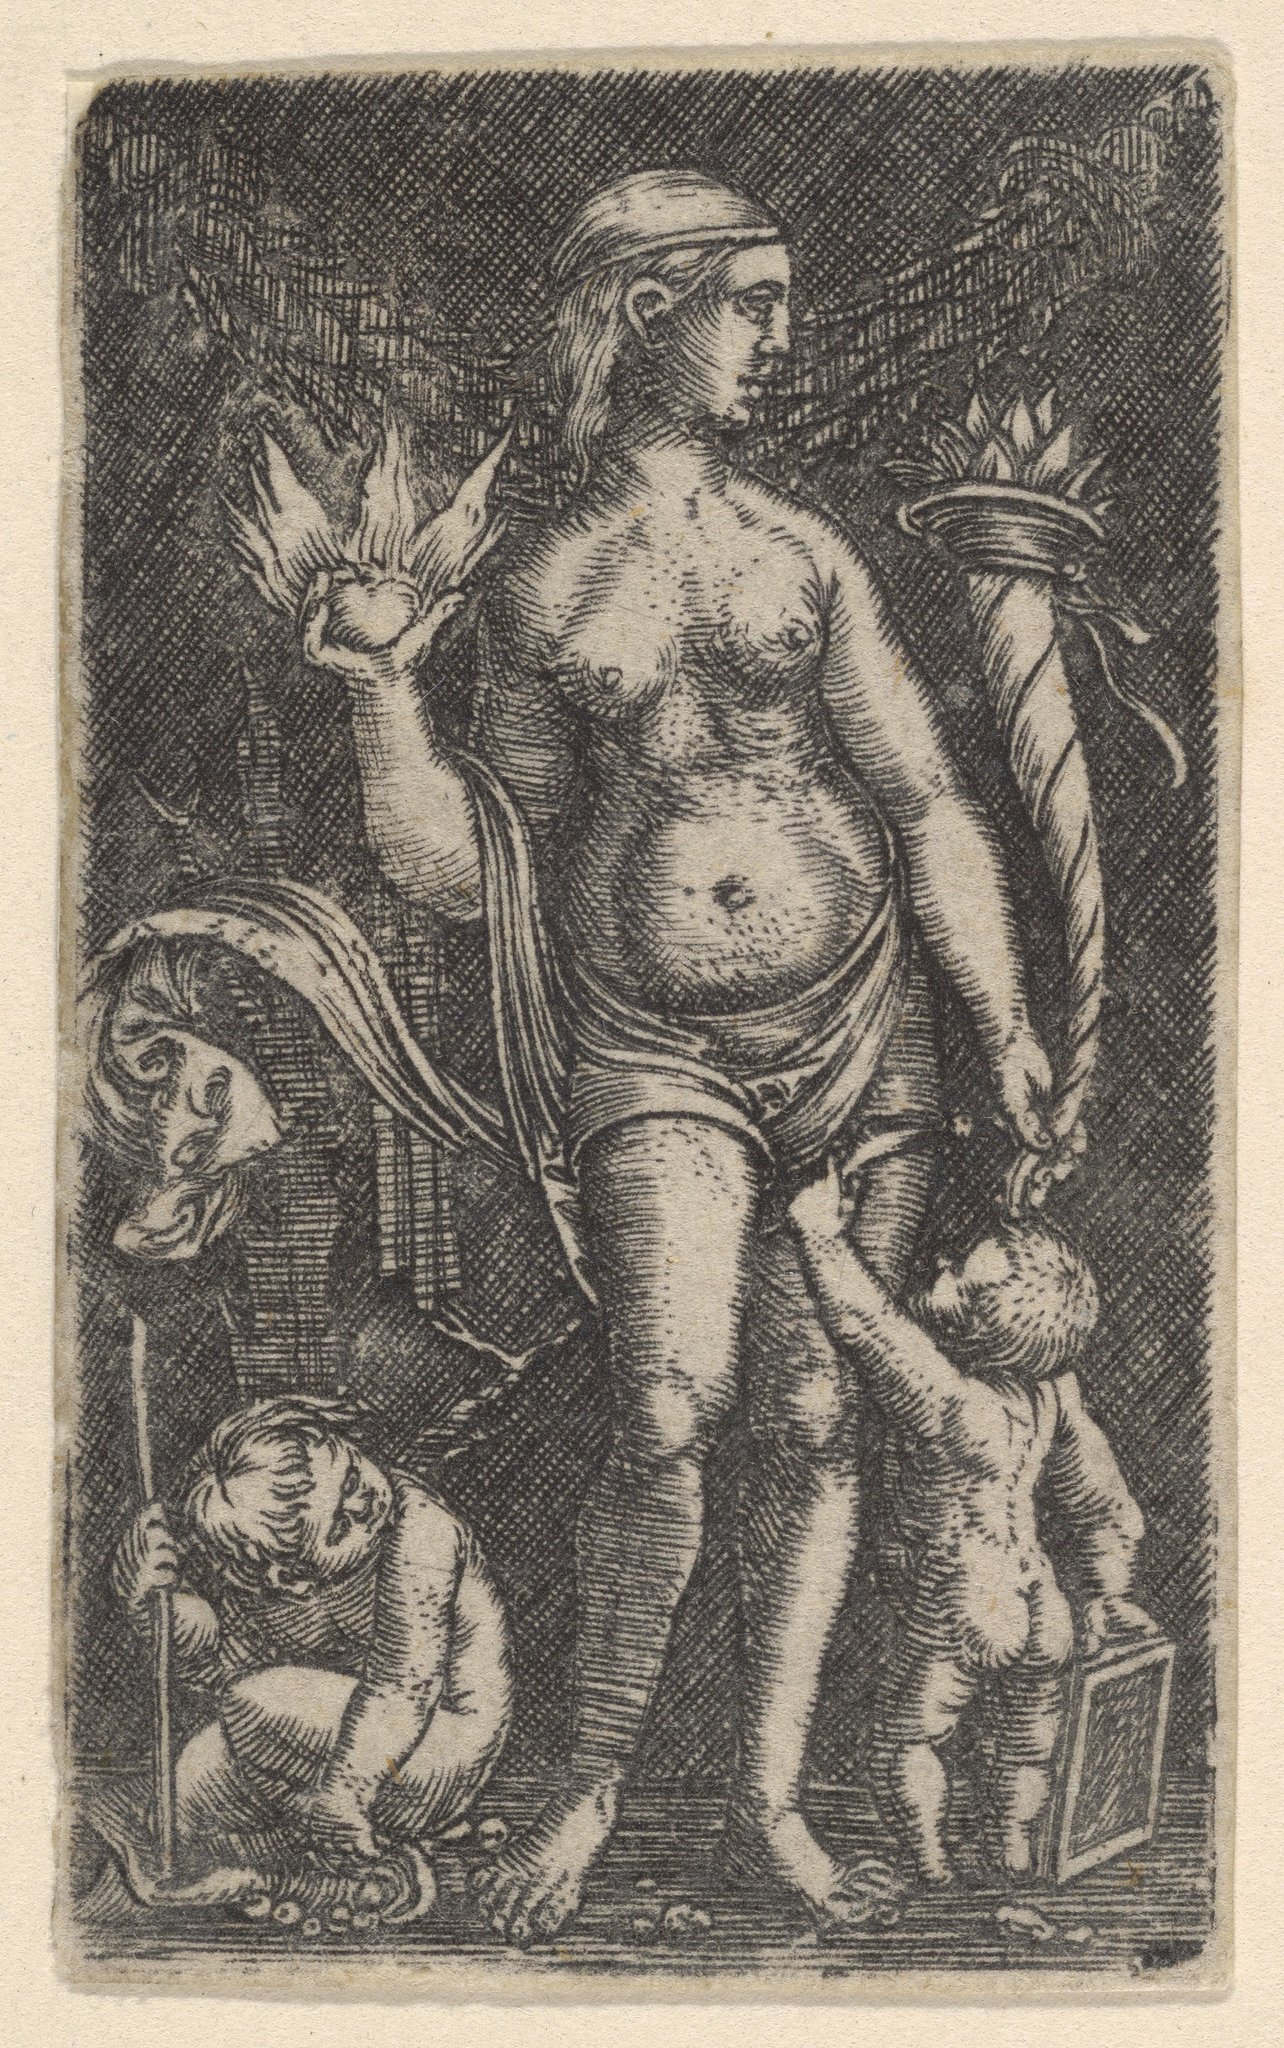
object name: print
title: Venus with Two Putti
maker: albrecht altdorfer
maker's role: artist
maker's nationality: german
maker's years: 1480-1538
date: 1500-1538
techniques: engraving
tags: putti,venus